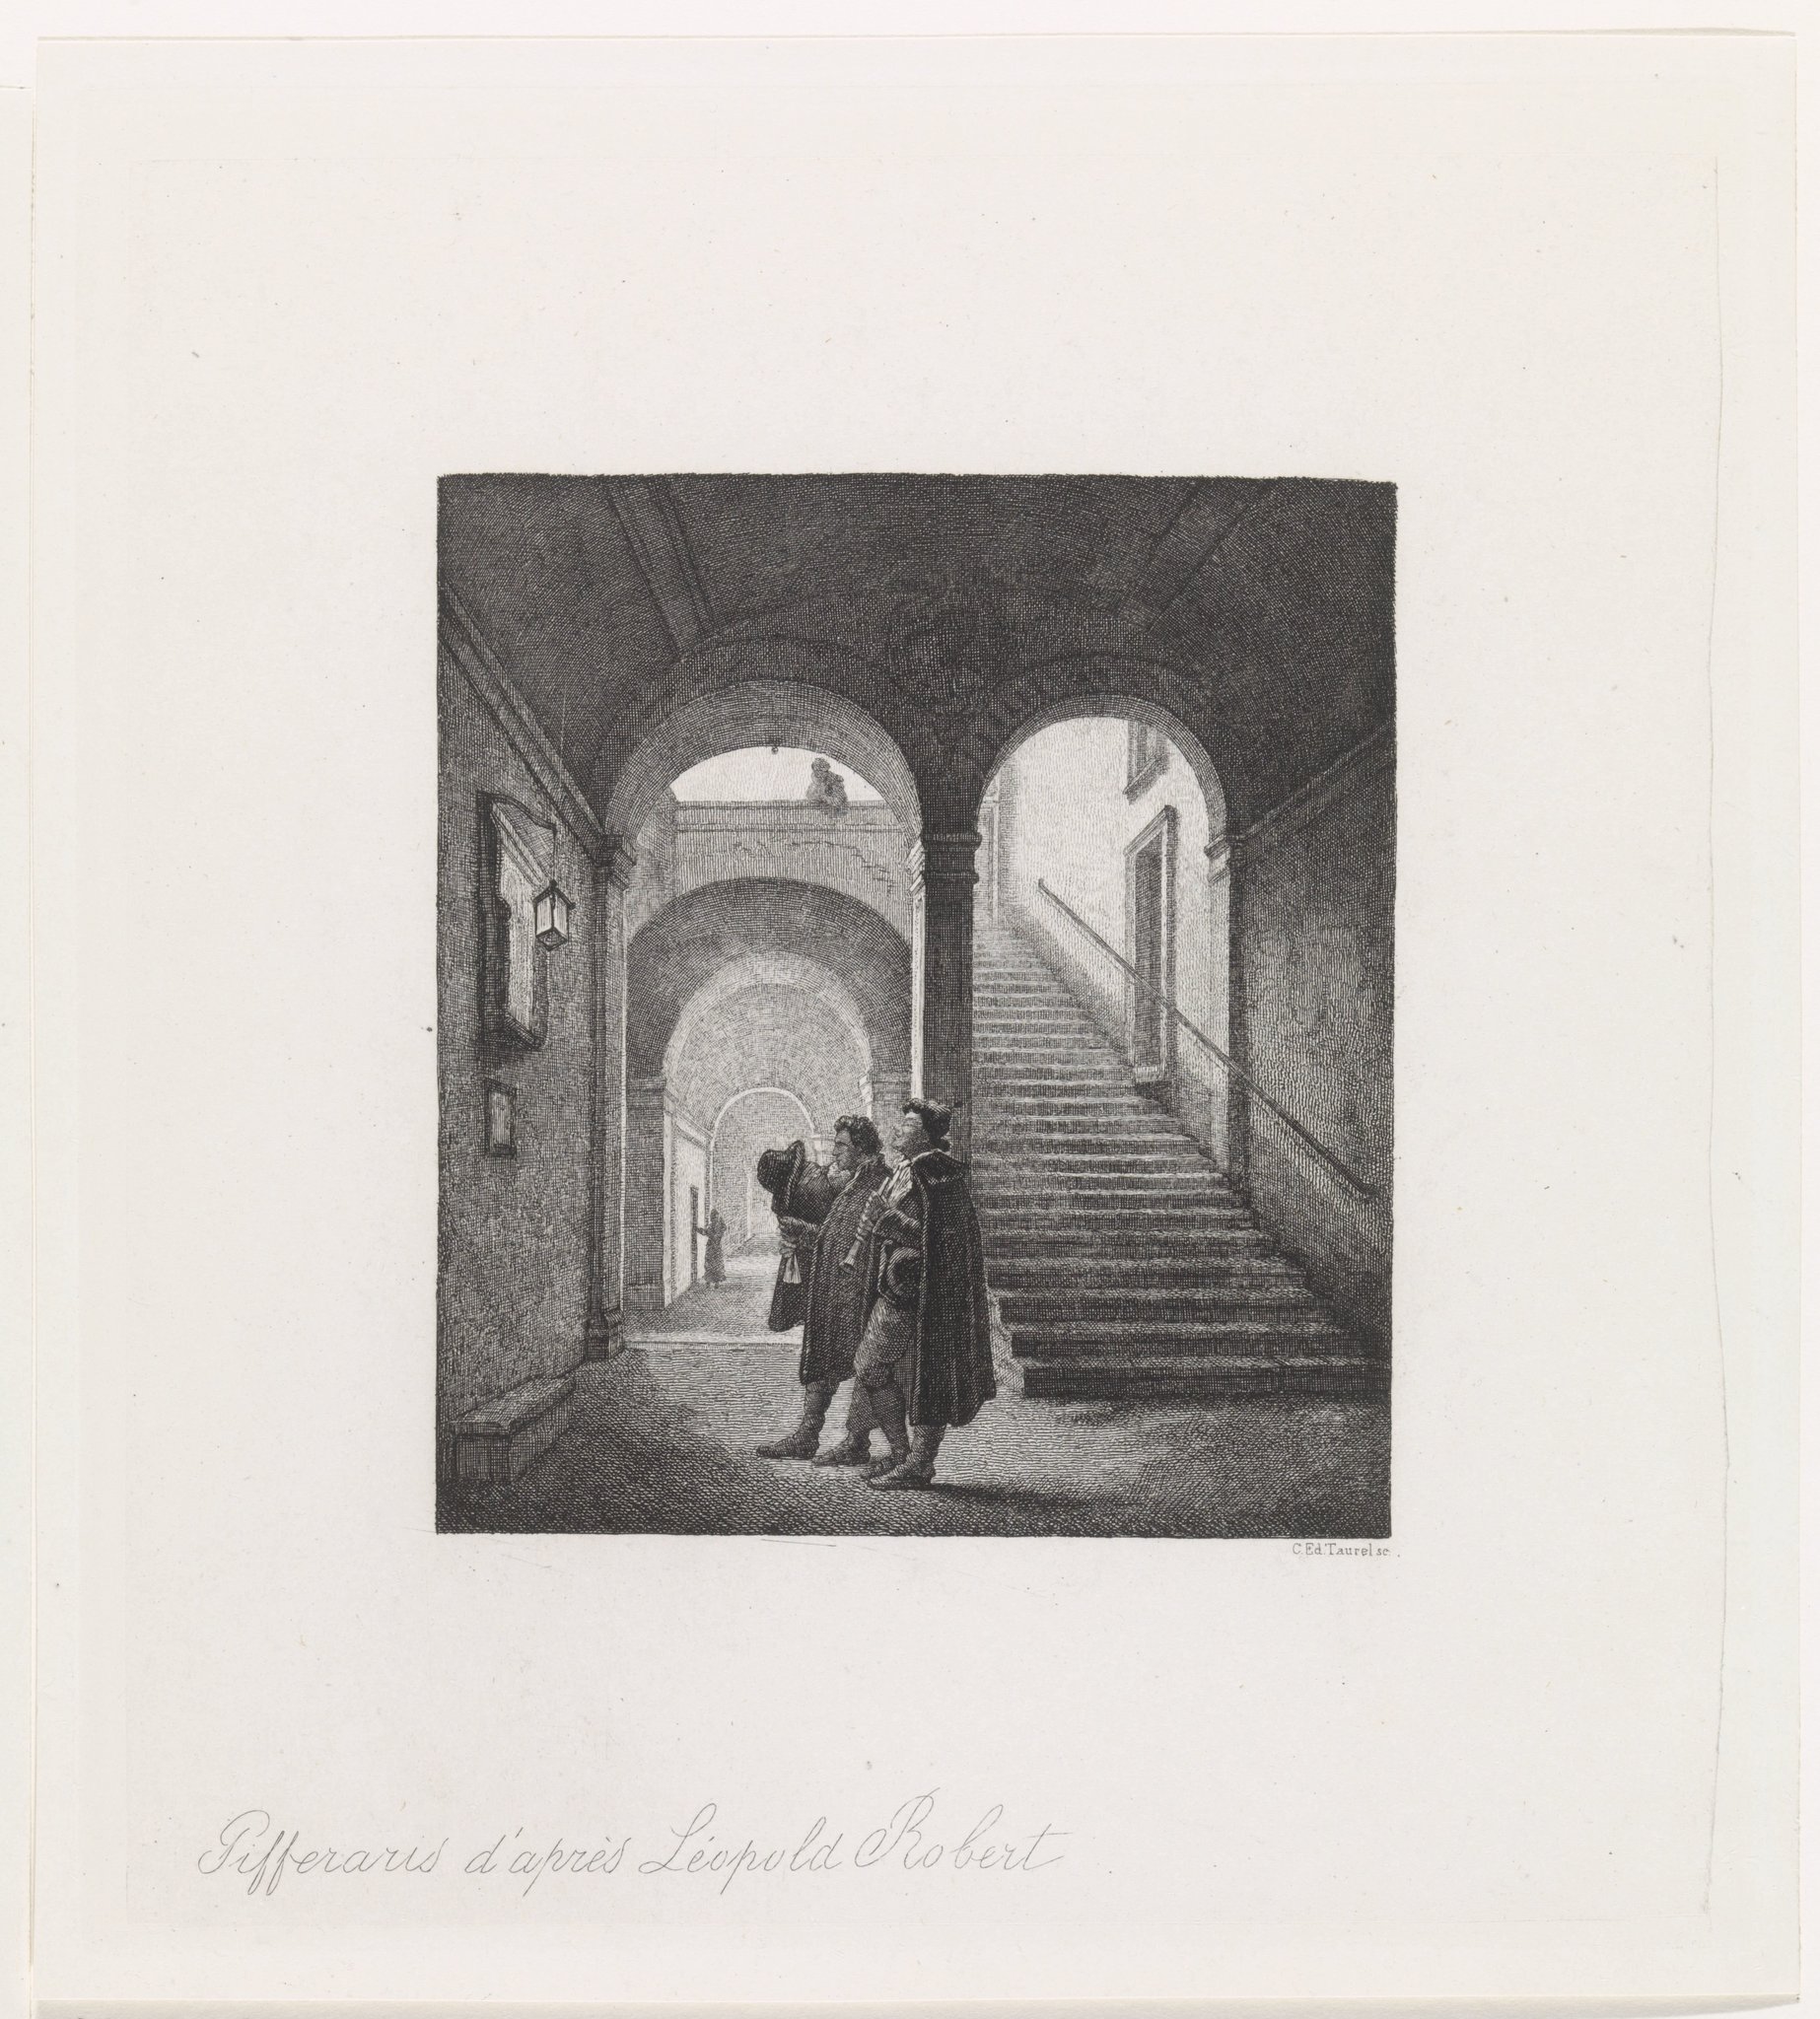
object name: print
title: Pifferaris d'après Léopold Robert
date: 1885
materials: paper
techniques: engraving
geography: amsterdam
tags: arch, archivolt ~ architecture, bagpipe, musette - cc - out of doors, staircase, flute, aulos, tibia - cc - out of doors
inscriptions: collector's mark: Lugt 2228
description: Prent ook gebruikt als illustratie in: L'album T. douze eaux-fortes d'après des dessins originaux et inédits de Jean Alaux, Léon Cogniet, Coutan, Henriquel Dupont, Ingres, Léopold Robert et Etna Michalon avec texte explicatif et biographique enrichi de lettres inédites. Amsterdam en Den Haag: 1885.